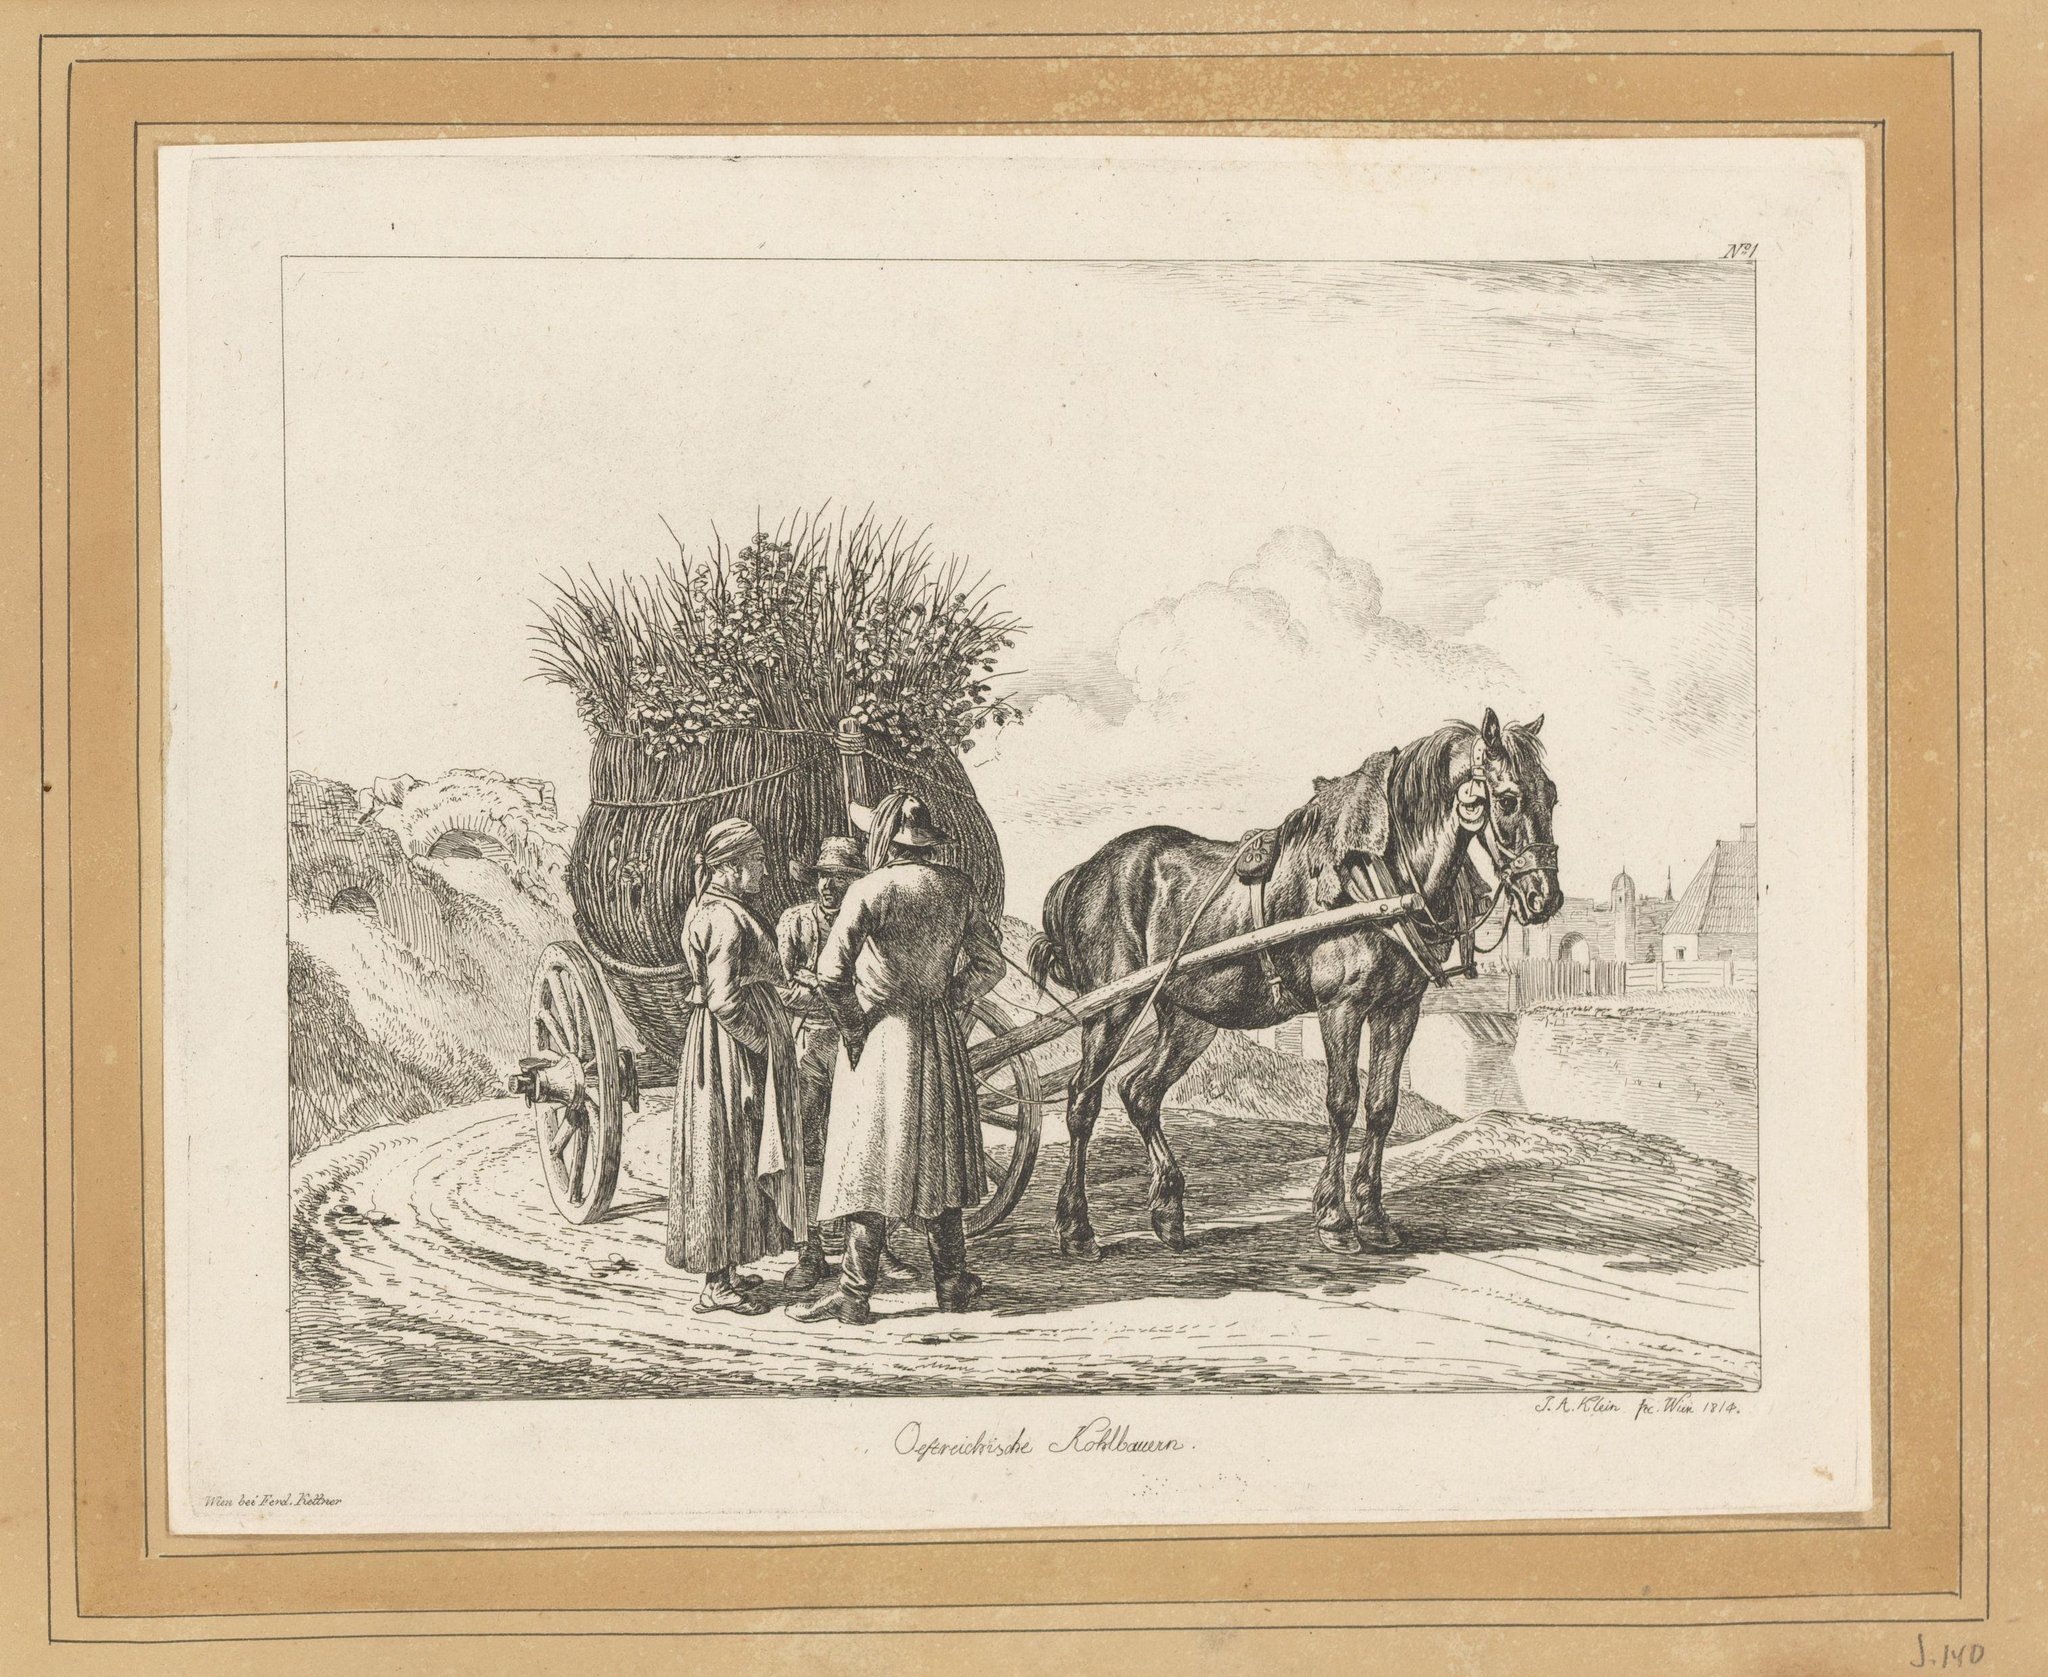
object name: album leaf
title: Drie boeren bij een trekkar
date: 1814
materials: paper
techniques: etching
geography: vienna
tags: farmers, horse, two-wheeled vehicle drawn by one animal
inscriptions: collector's mark: Lugt 2228, : Lugt 2760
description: Genummerd rechtsboven: 1. Prent maakt deel uit van een album.